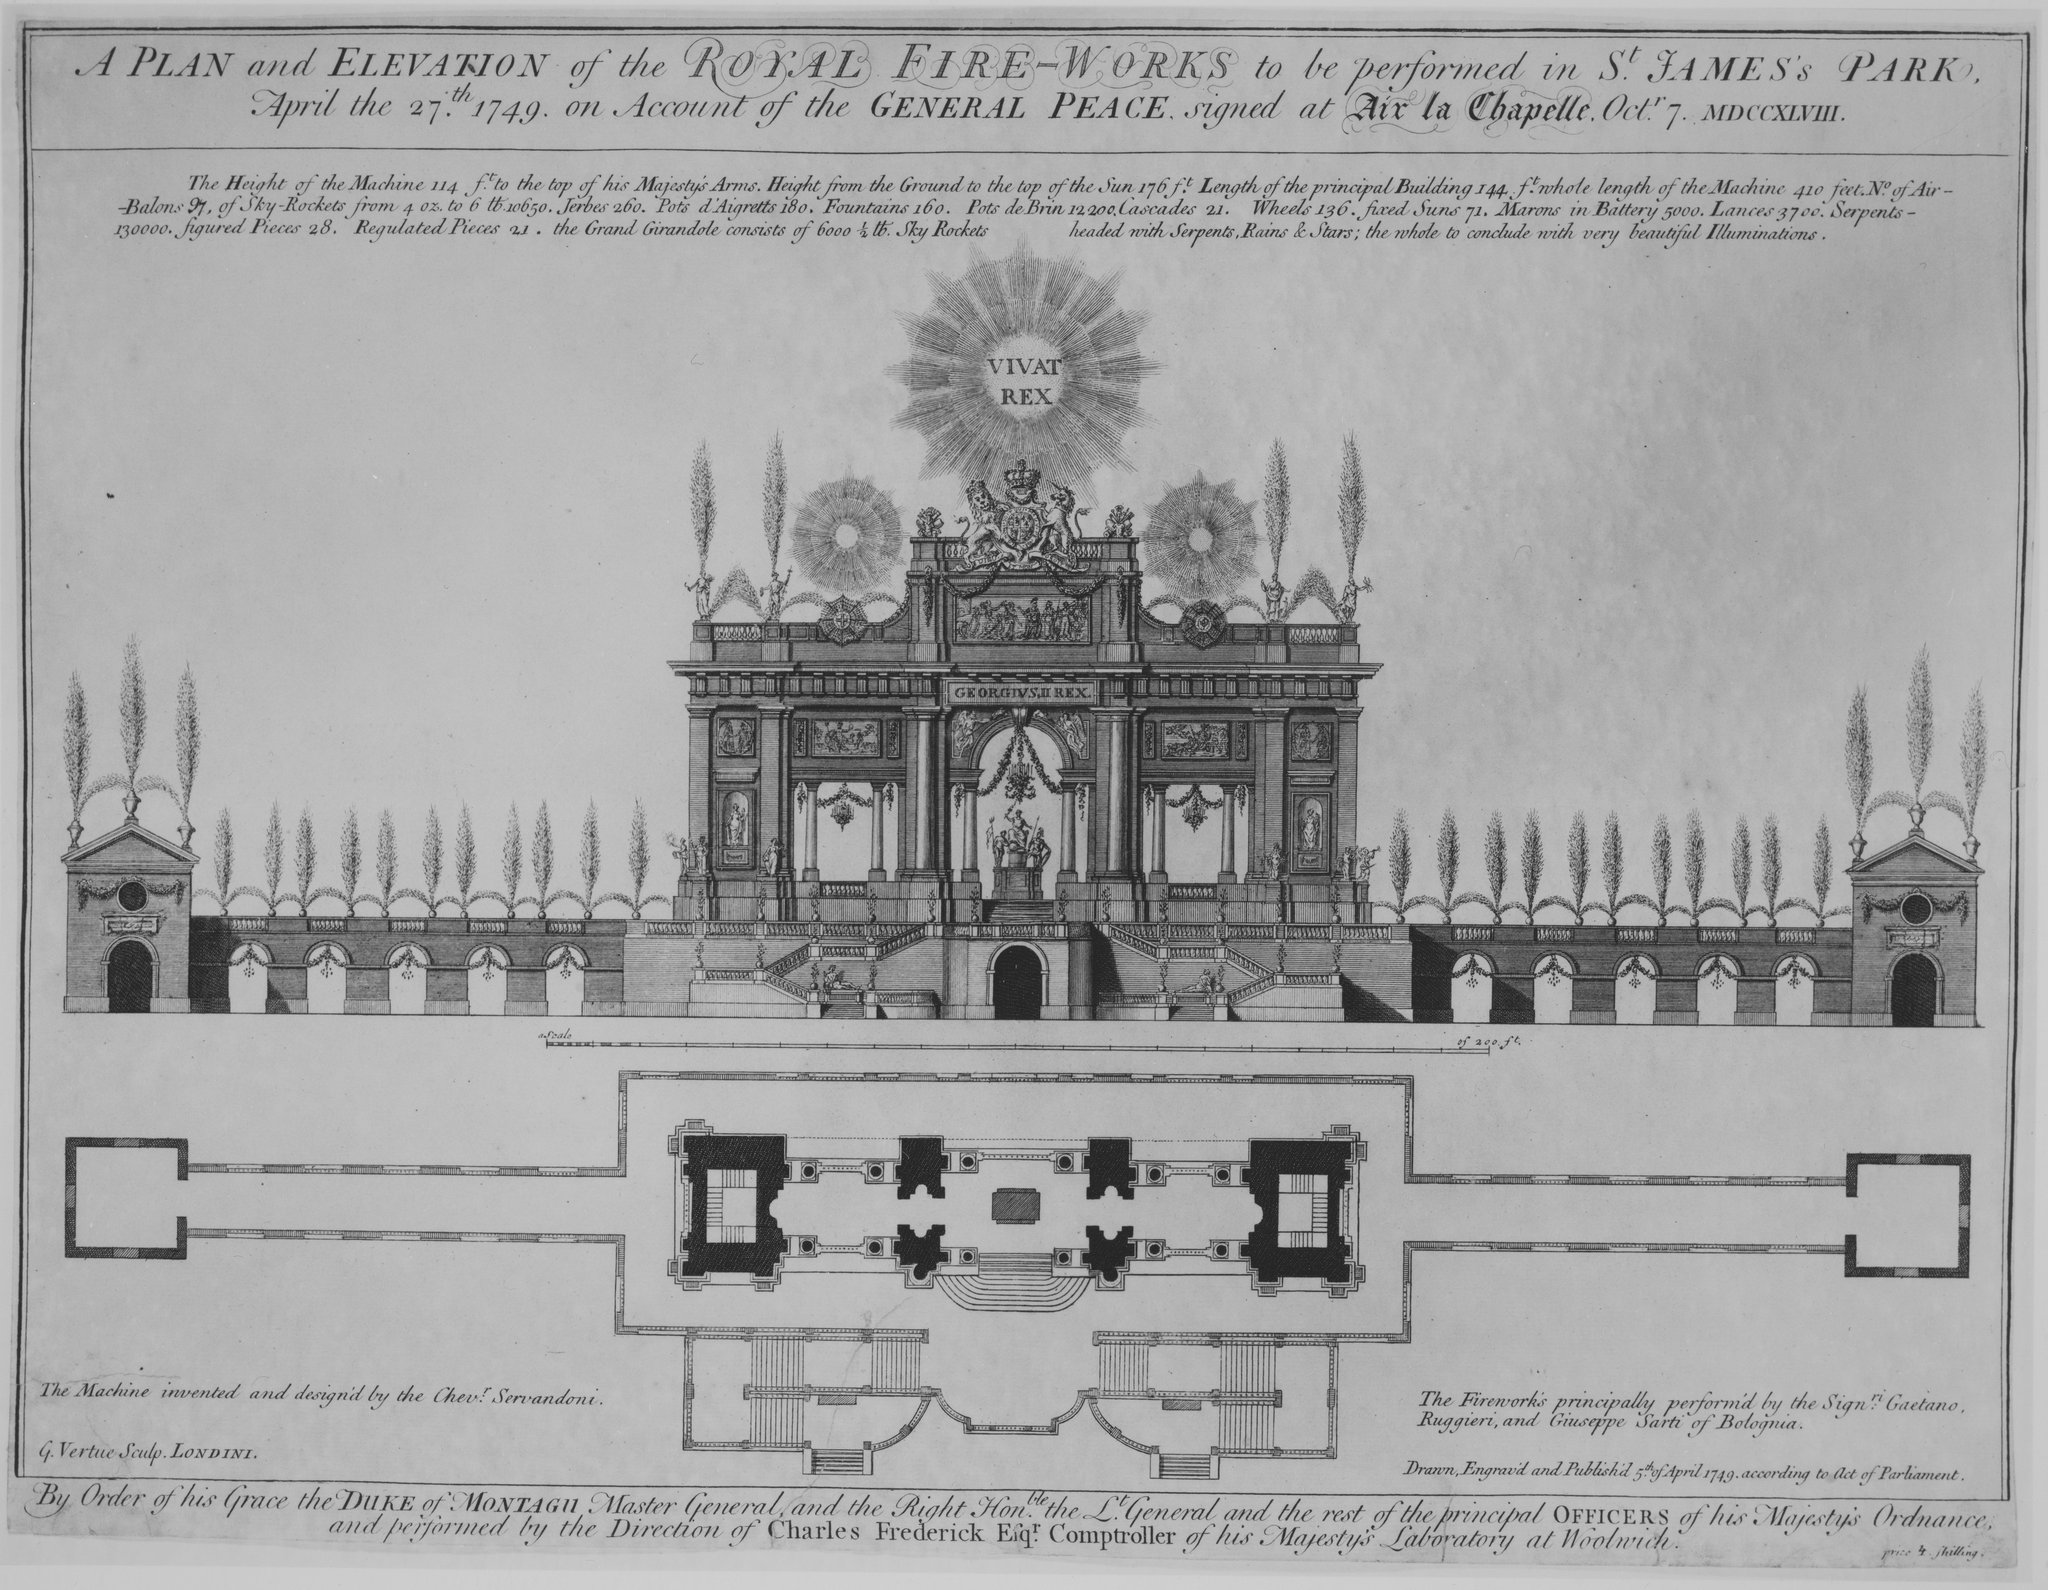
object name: print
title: Peace of Aix-la-Chapelle: A Plan and Elevation of the Royal Fire-Works, London, 1749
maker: george vertue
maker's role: artist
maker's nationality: british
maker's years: 1684-1756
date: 1749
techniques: engraving, etching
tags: architecture,buildings,london